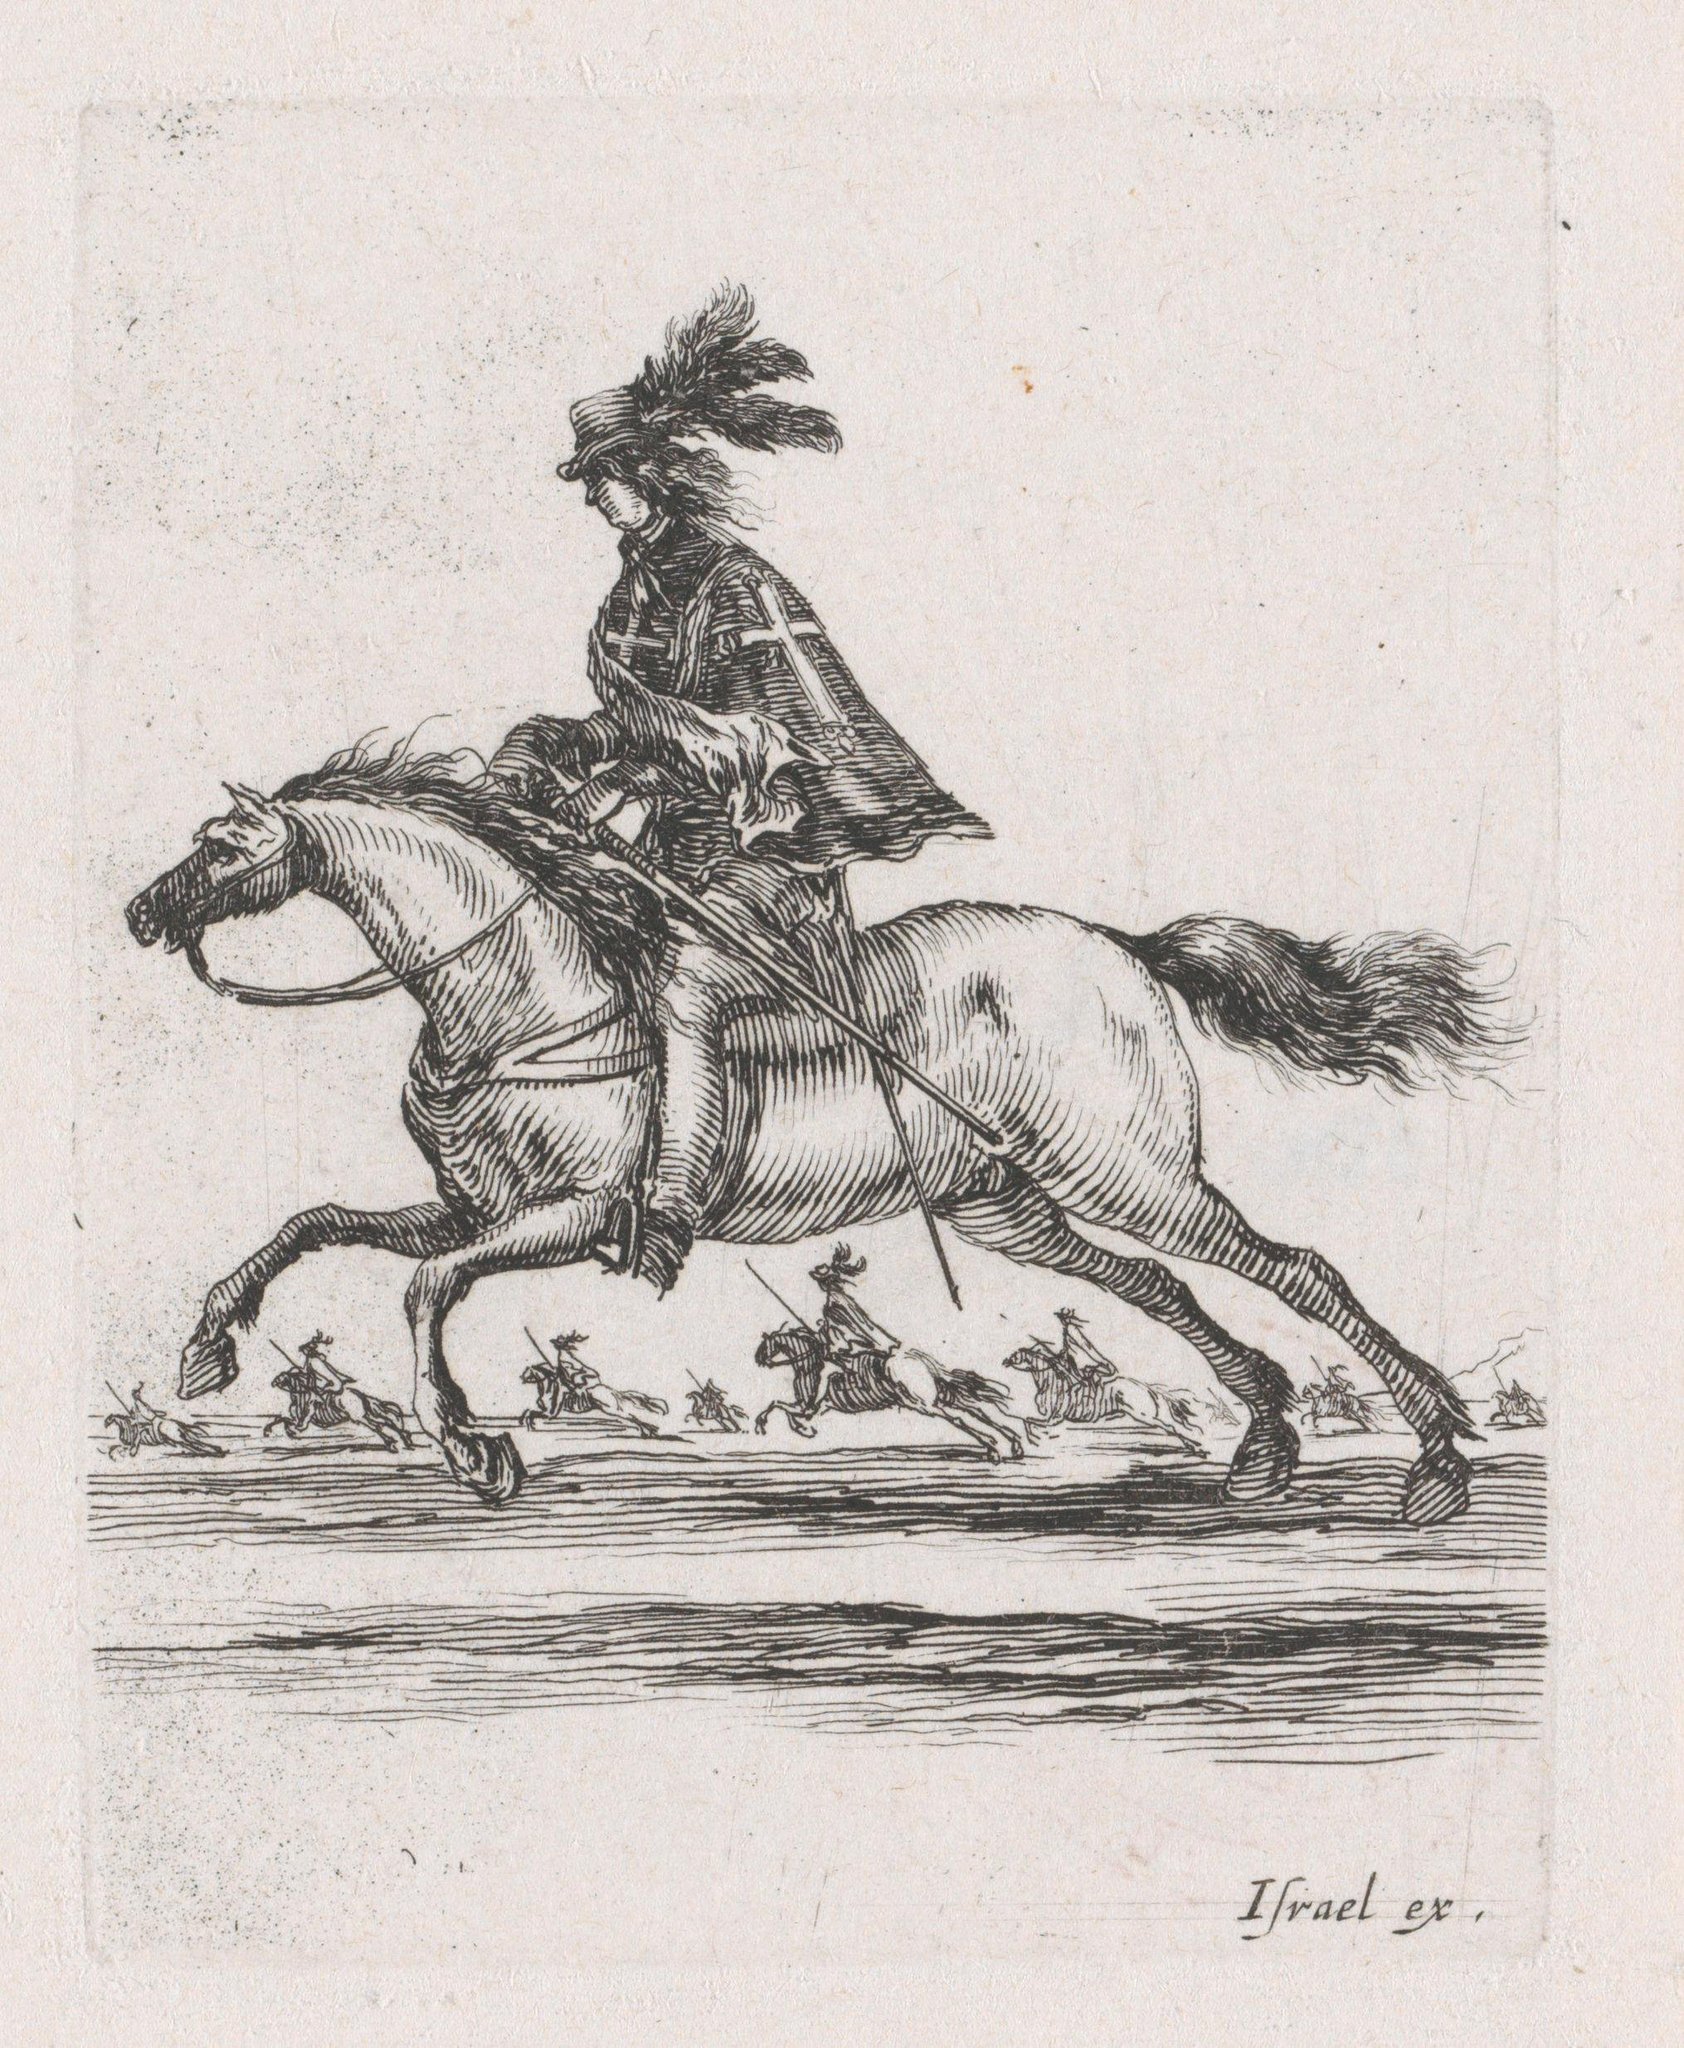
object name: print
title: Musketier te paard in een landschap met meer ruiters te paard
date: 1620-1664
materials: paper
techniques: etching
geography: paris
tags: riding a horse, ass, or mule; rider, horseman, the soldier; the soldier's life, horse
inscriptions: collector's mark: Lugt 240